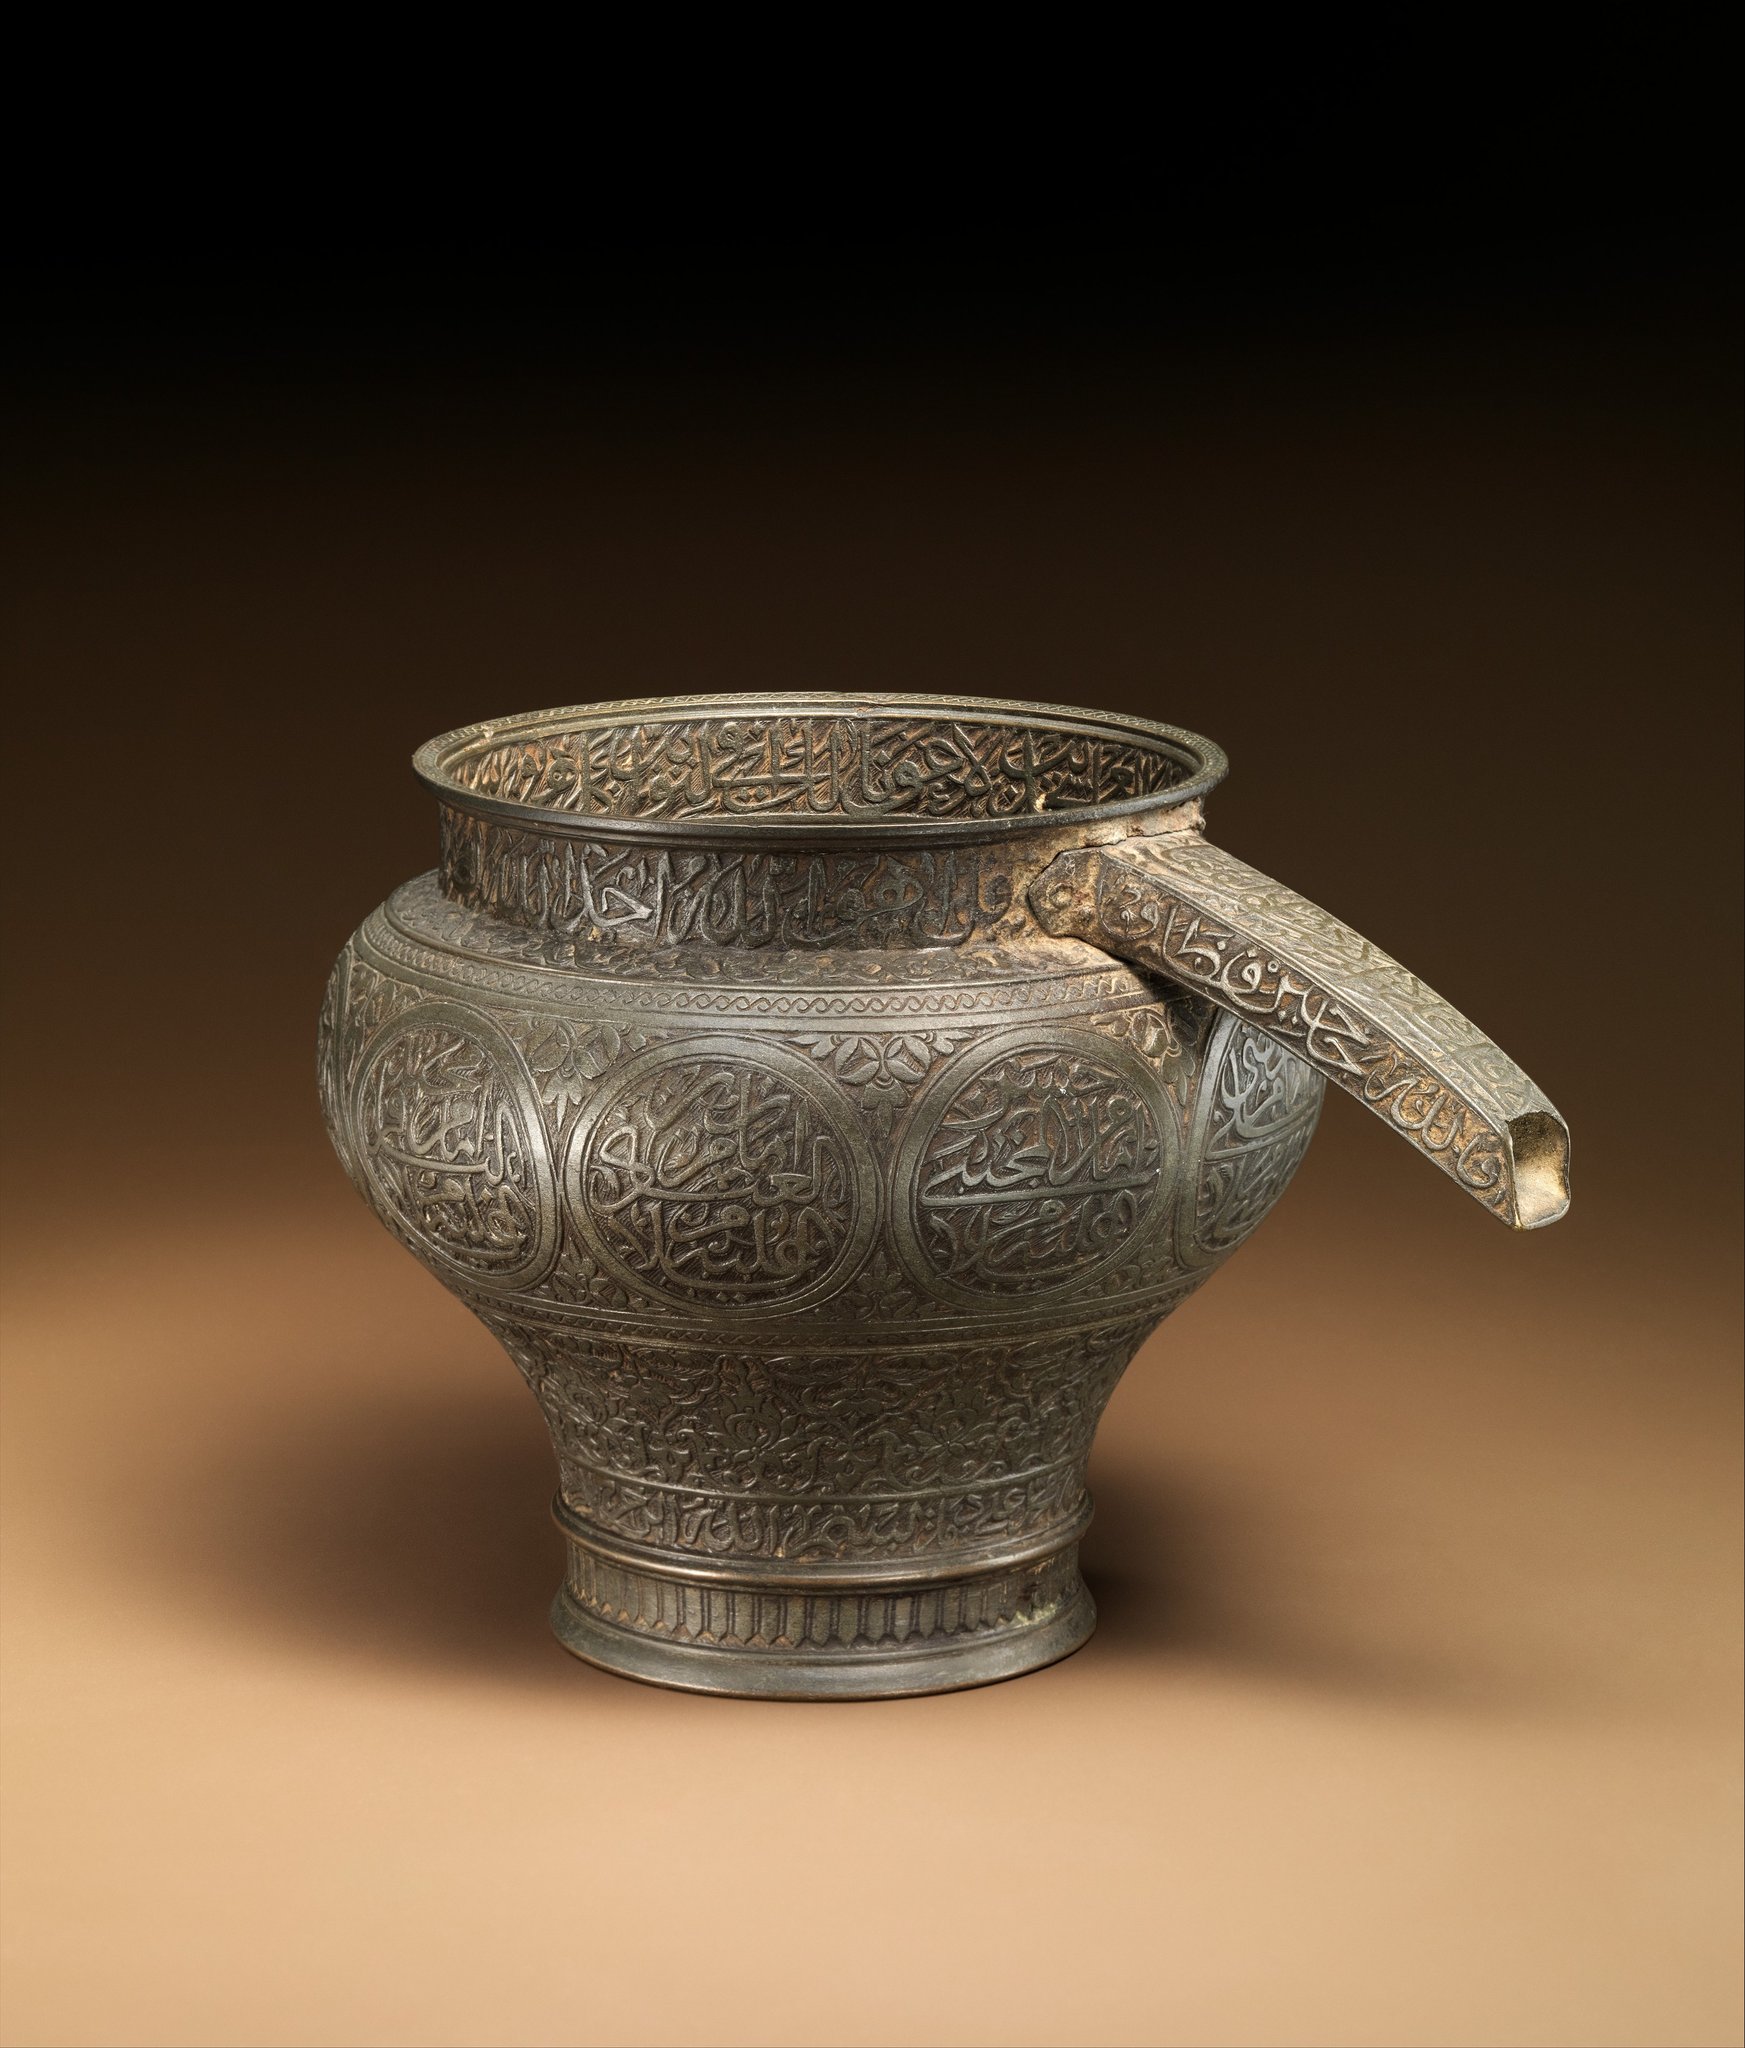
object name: ewer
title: Spouted Vessel with Qur'anic Verses and the Names of the Shi'a Imams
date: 1601-1700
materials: copper alloy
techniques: chasing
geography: india